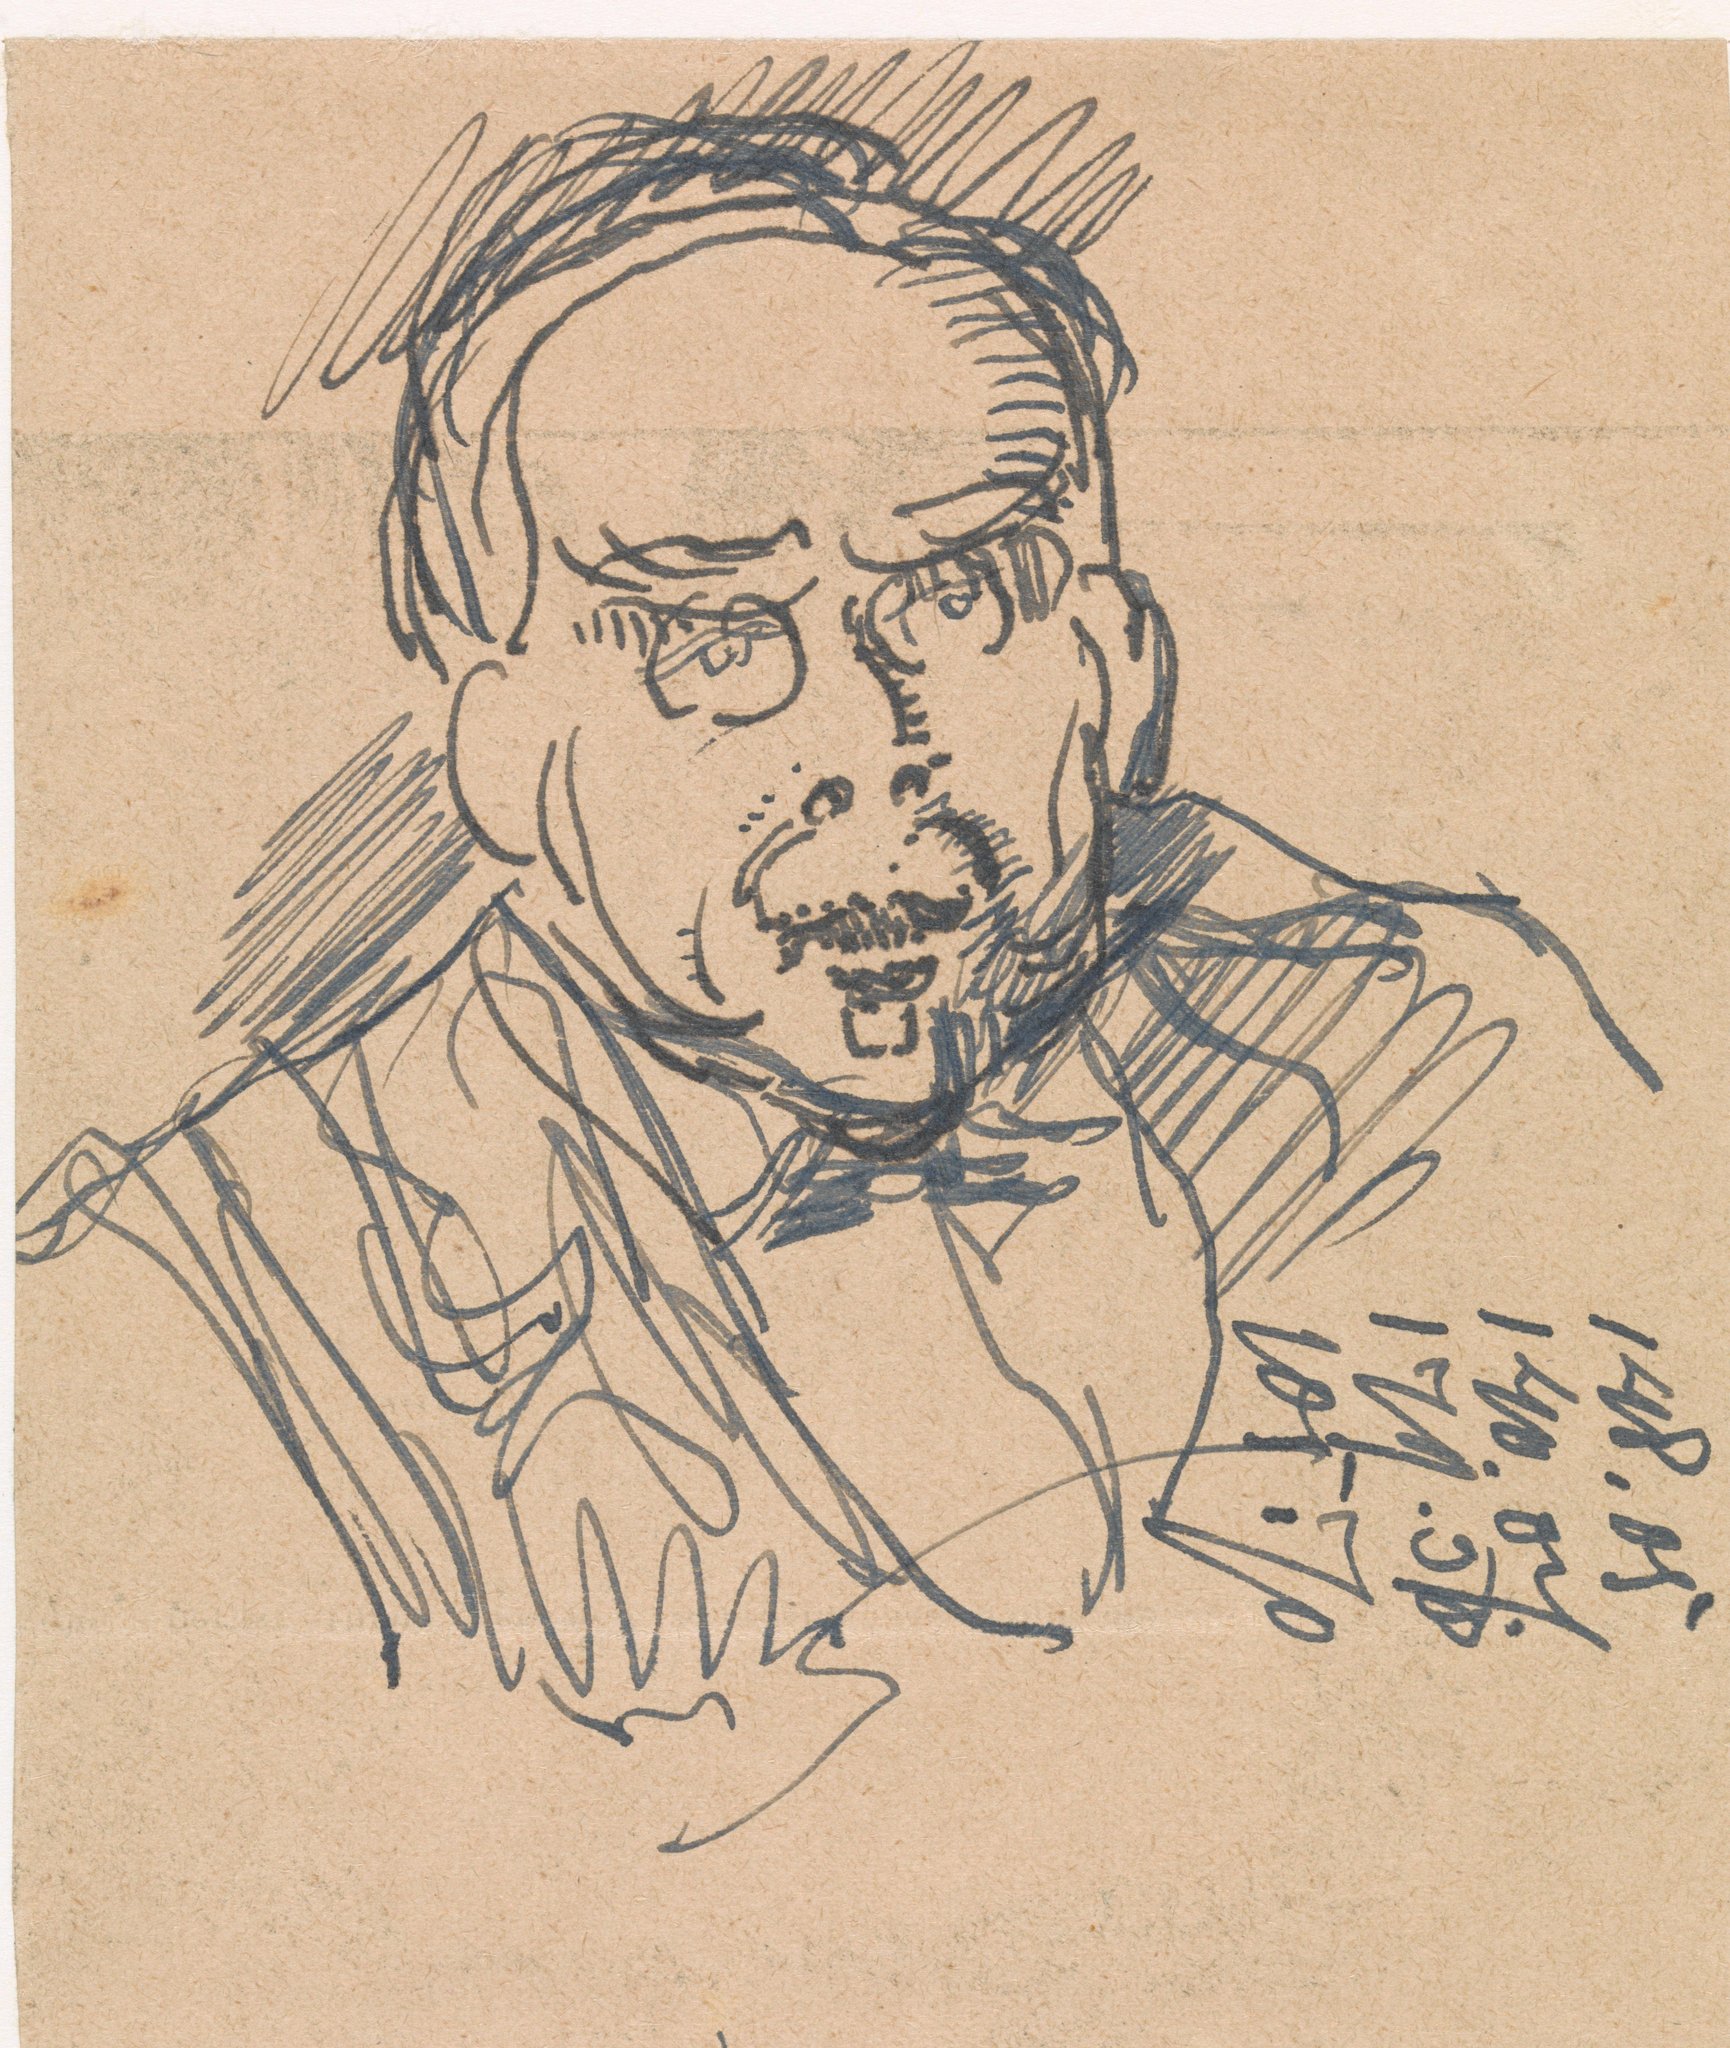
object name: drawing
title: Portret van een heer met een bril, driekwart naar rechts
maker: antoon derkinderen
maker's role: draughtsman, painter, print maker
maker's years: 1859-1925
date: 1869-1925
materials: ink, paper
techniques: pen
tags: anonymous historical person portrayed alone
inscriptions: annotation: ‘A.J. der Kinderen. Schetsportret van een bezoeker op de Academie, 's avonds thuis aan de thee uit het hoofd gekrabbeld.’